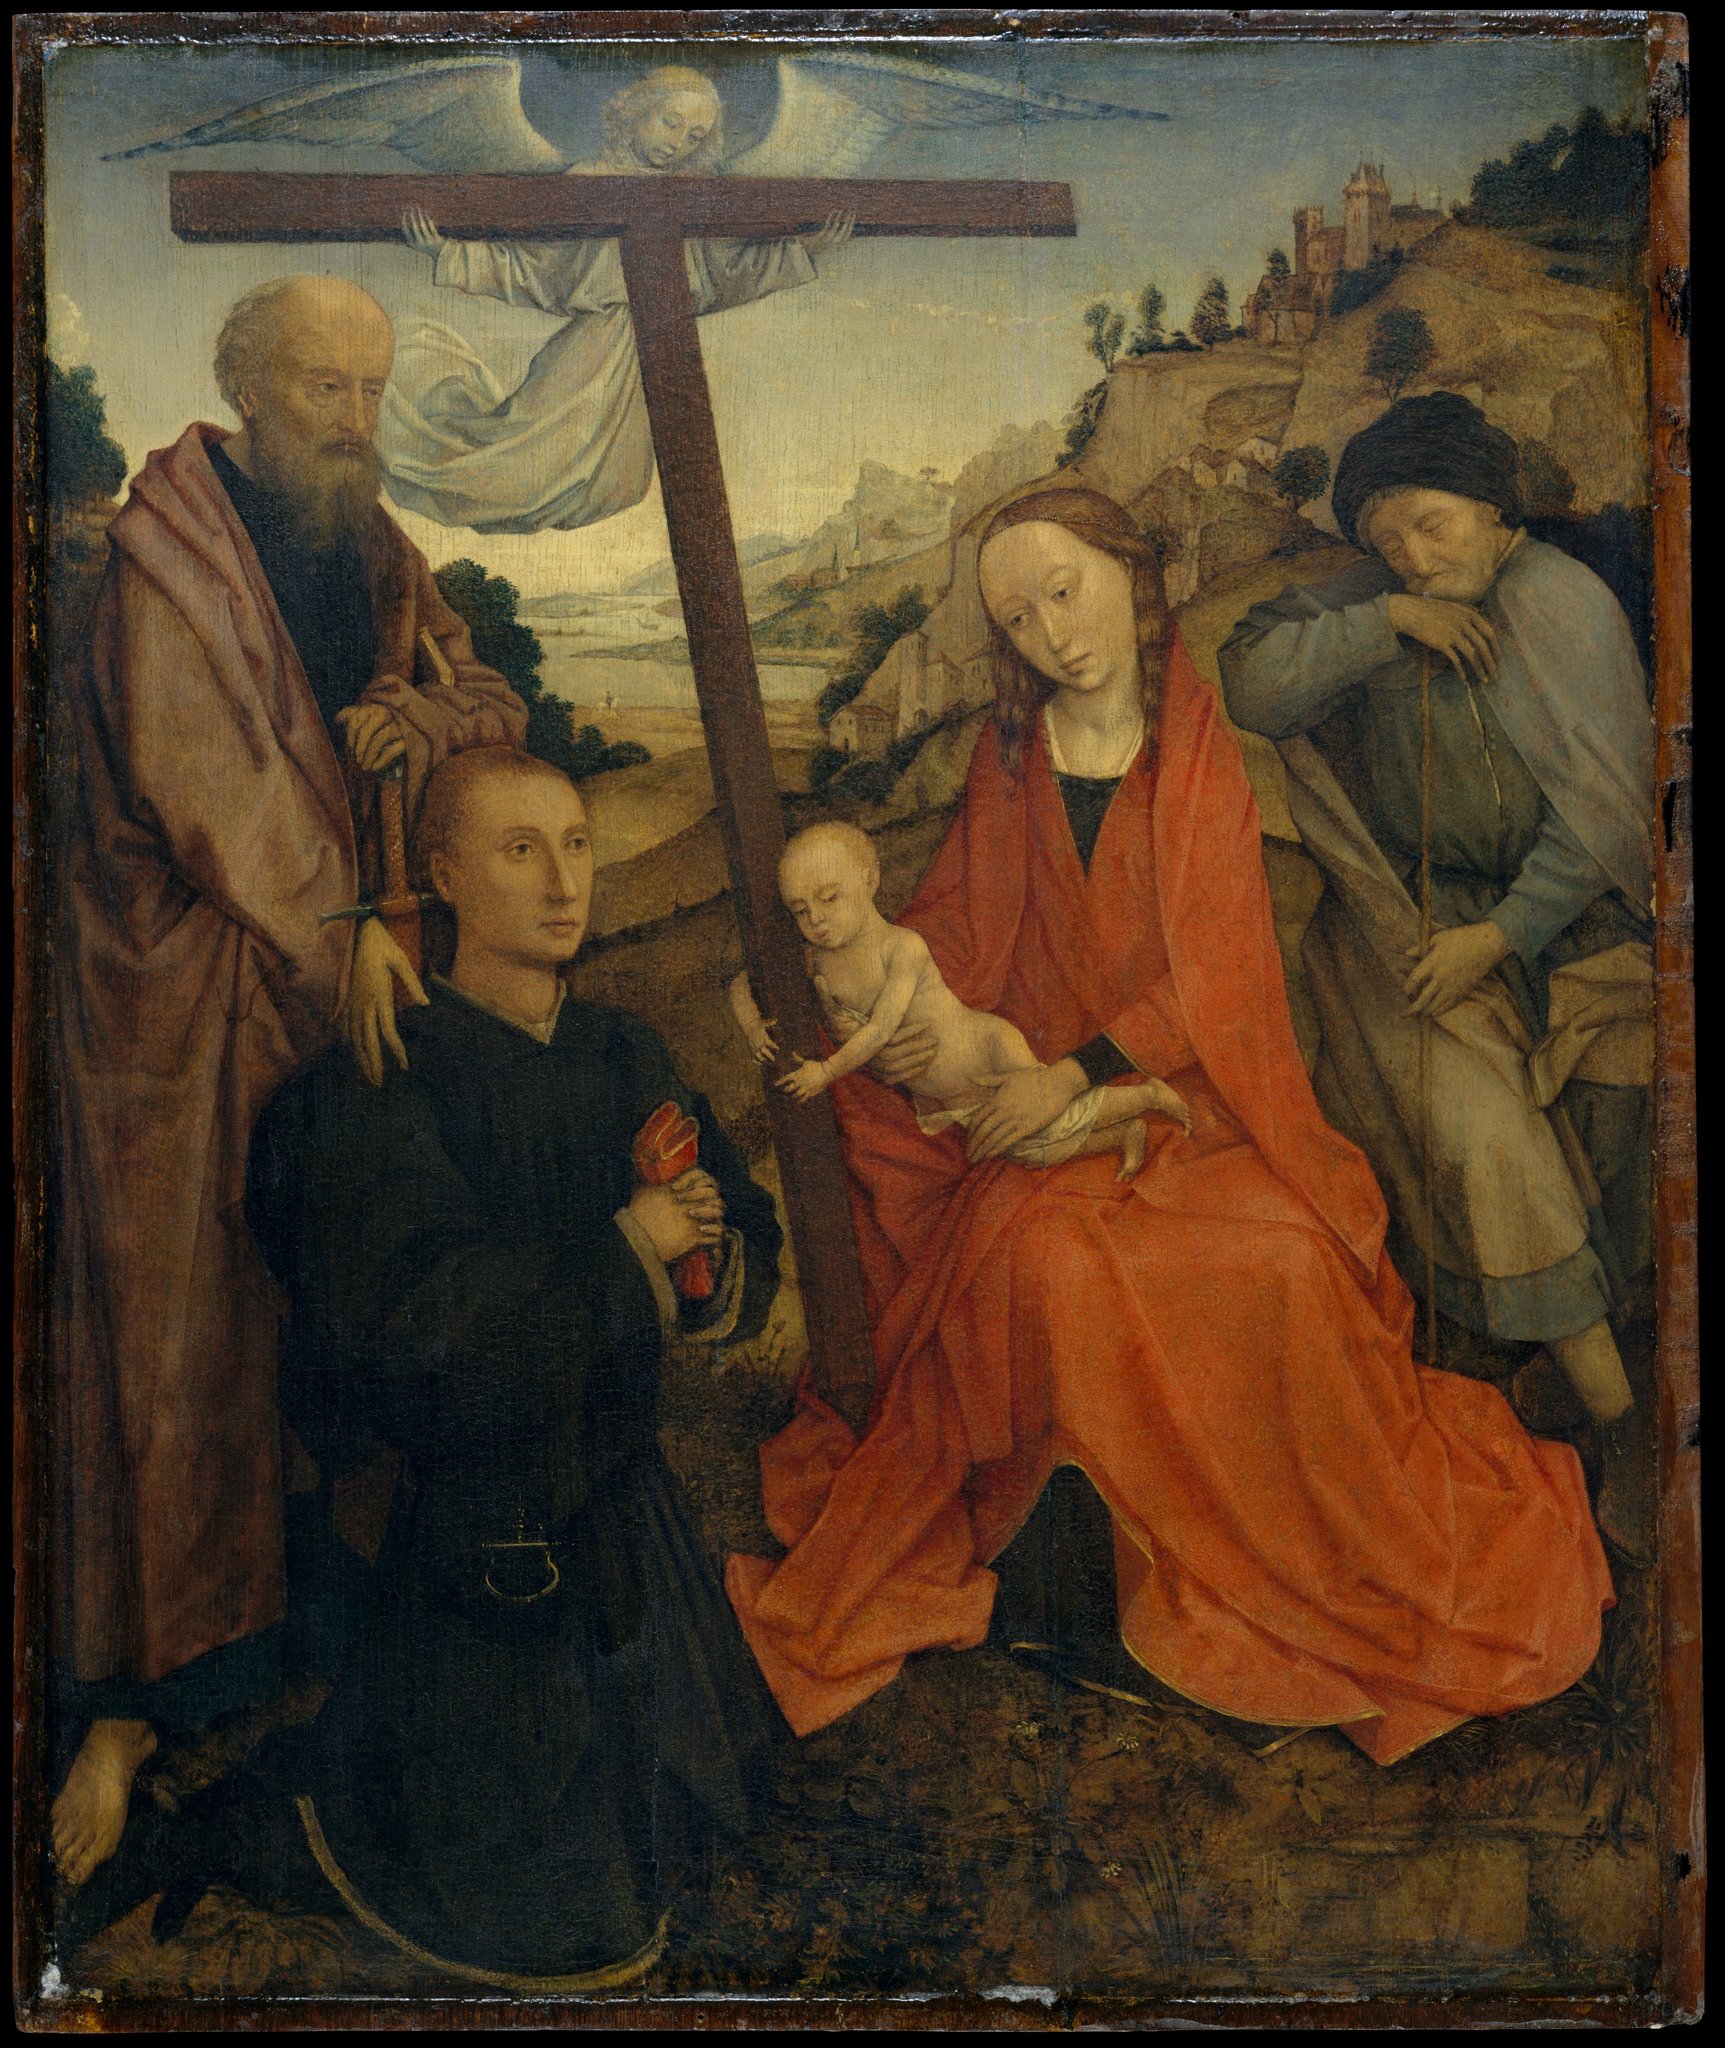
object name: painting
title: The Holy Family with Saint Paul and a Donor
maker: rogier van der weyden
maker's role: artist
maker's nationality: netherlandish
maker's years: 1399-1464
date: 1430-1469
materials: oil, wood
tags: women,angels,holy family,saint paul,cross